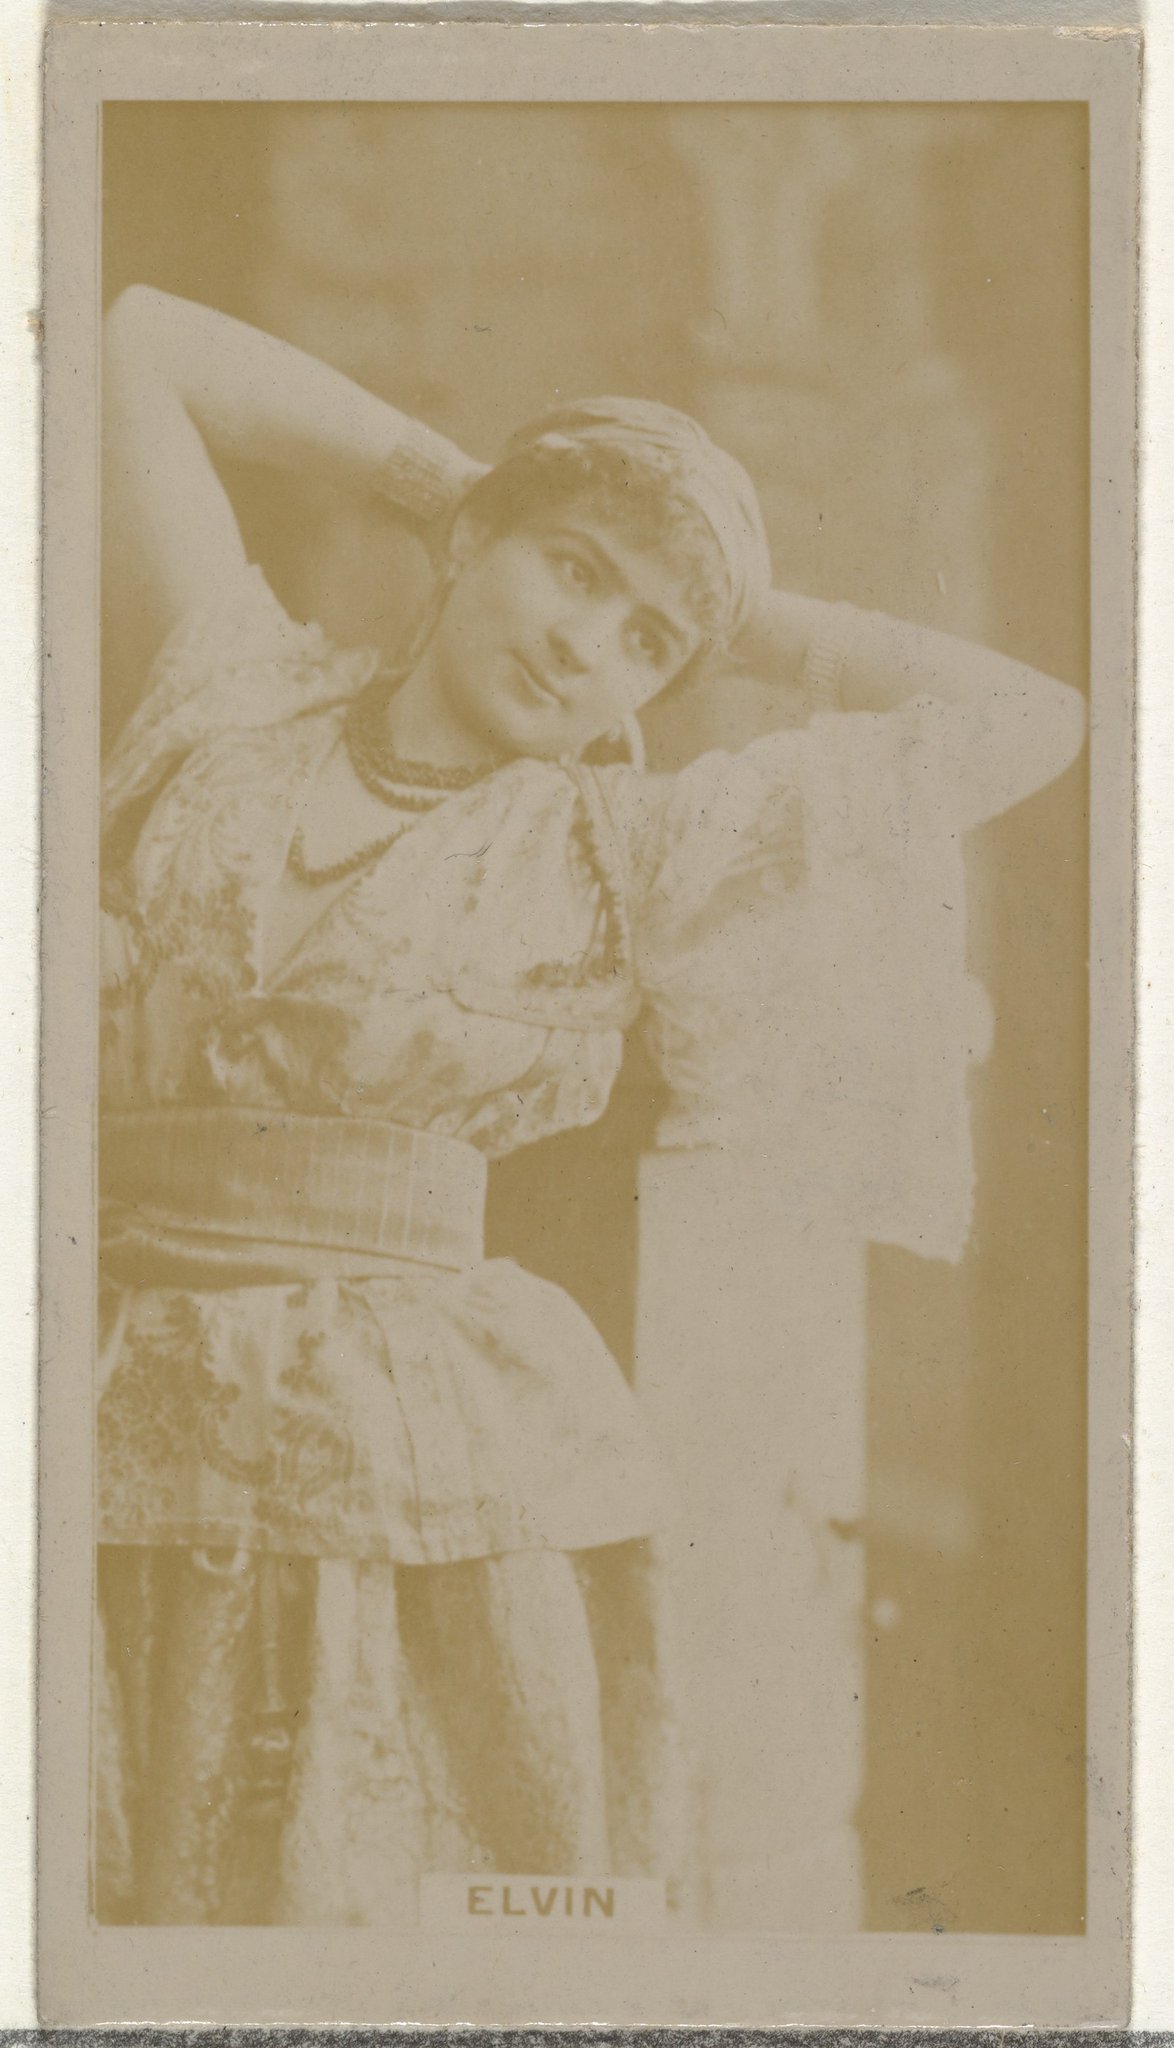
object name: photograph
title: Miss Elvin, from the Actors and Actresses series (N145-8) issued by Duke Sons & Co. to promote Duke Cigarettes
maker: w. duke, sons & co.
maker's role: publisher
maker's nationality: american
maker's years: 1870-1920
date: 1891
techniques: albumen silver print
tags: portraits,women,actresses